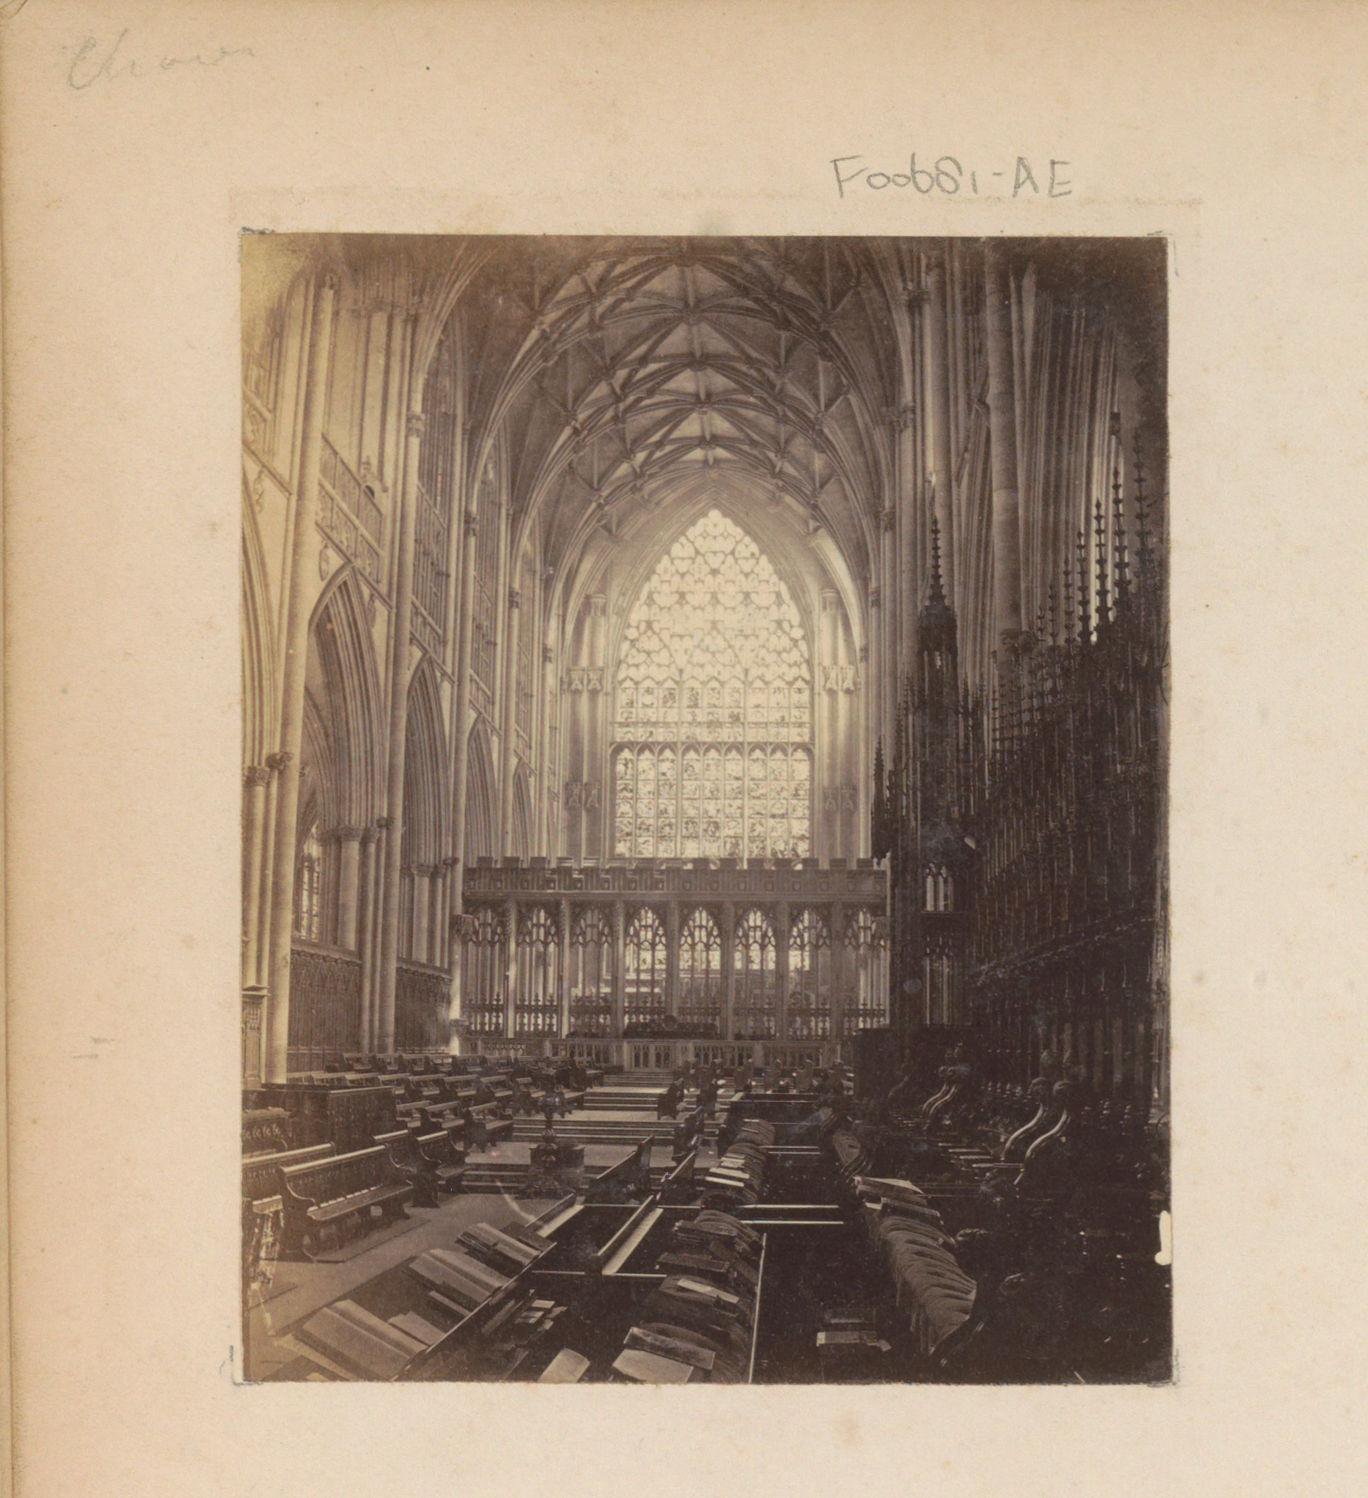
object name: photograph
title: Schip en het koorhek van een kathedraal in Engeland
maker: Anonymous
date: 1850-1870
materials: paper, photographic support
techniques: albumen print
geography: england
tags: rood-screen, choir-screen; iconostasis, parts of church interior: nave, england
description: Onderdeel van Album met foto's van bezienswaardigheden en landschappen in Engeland en van kunst.